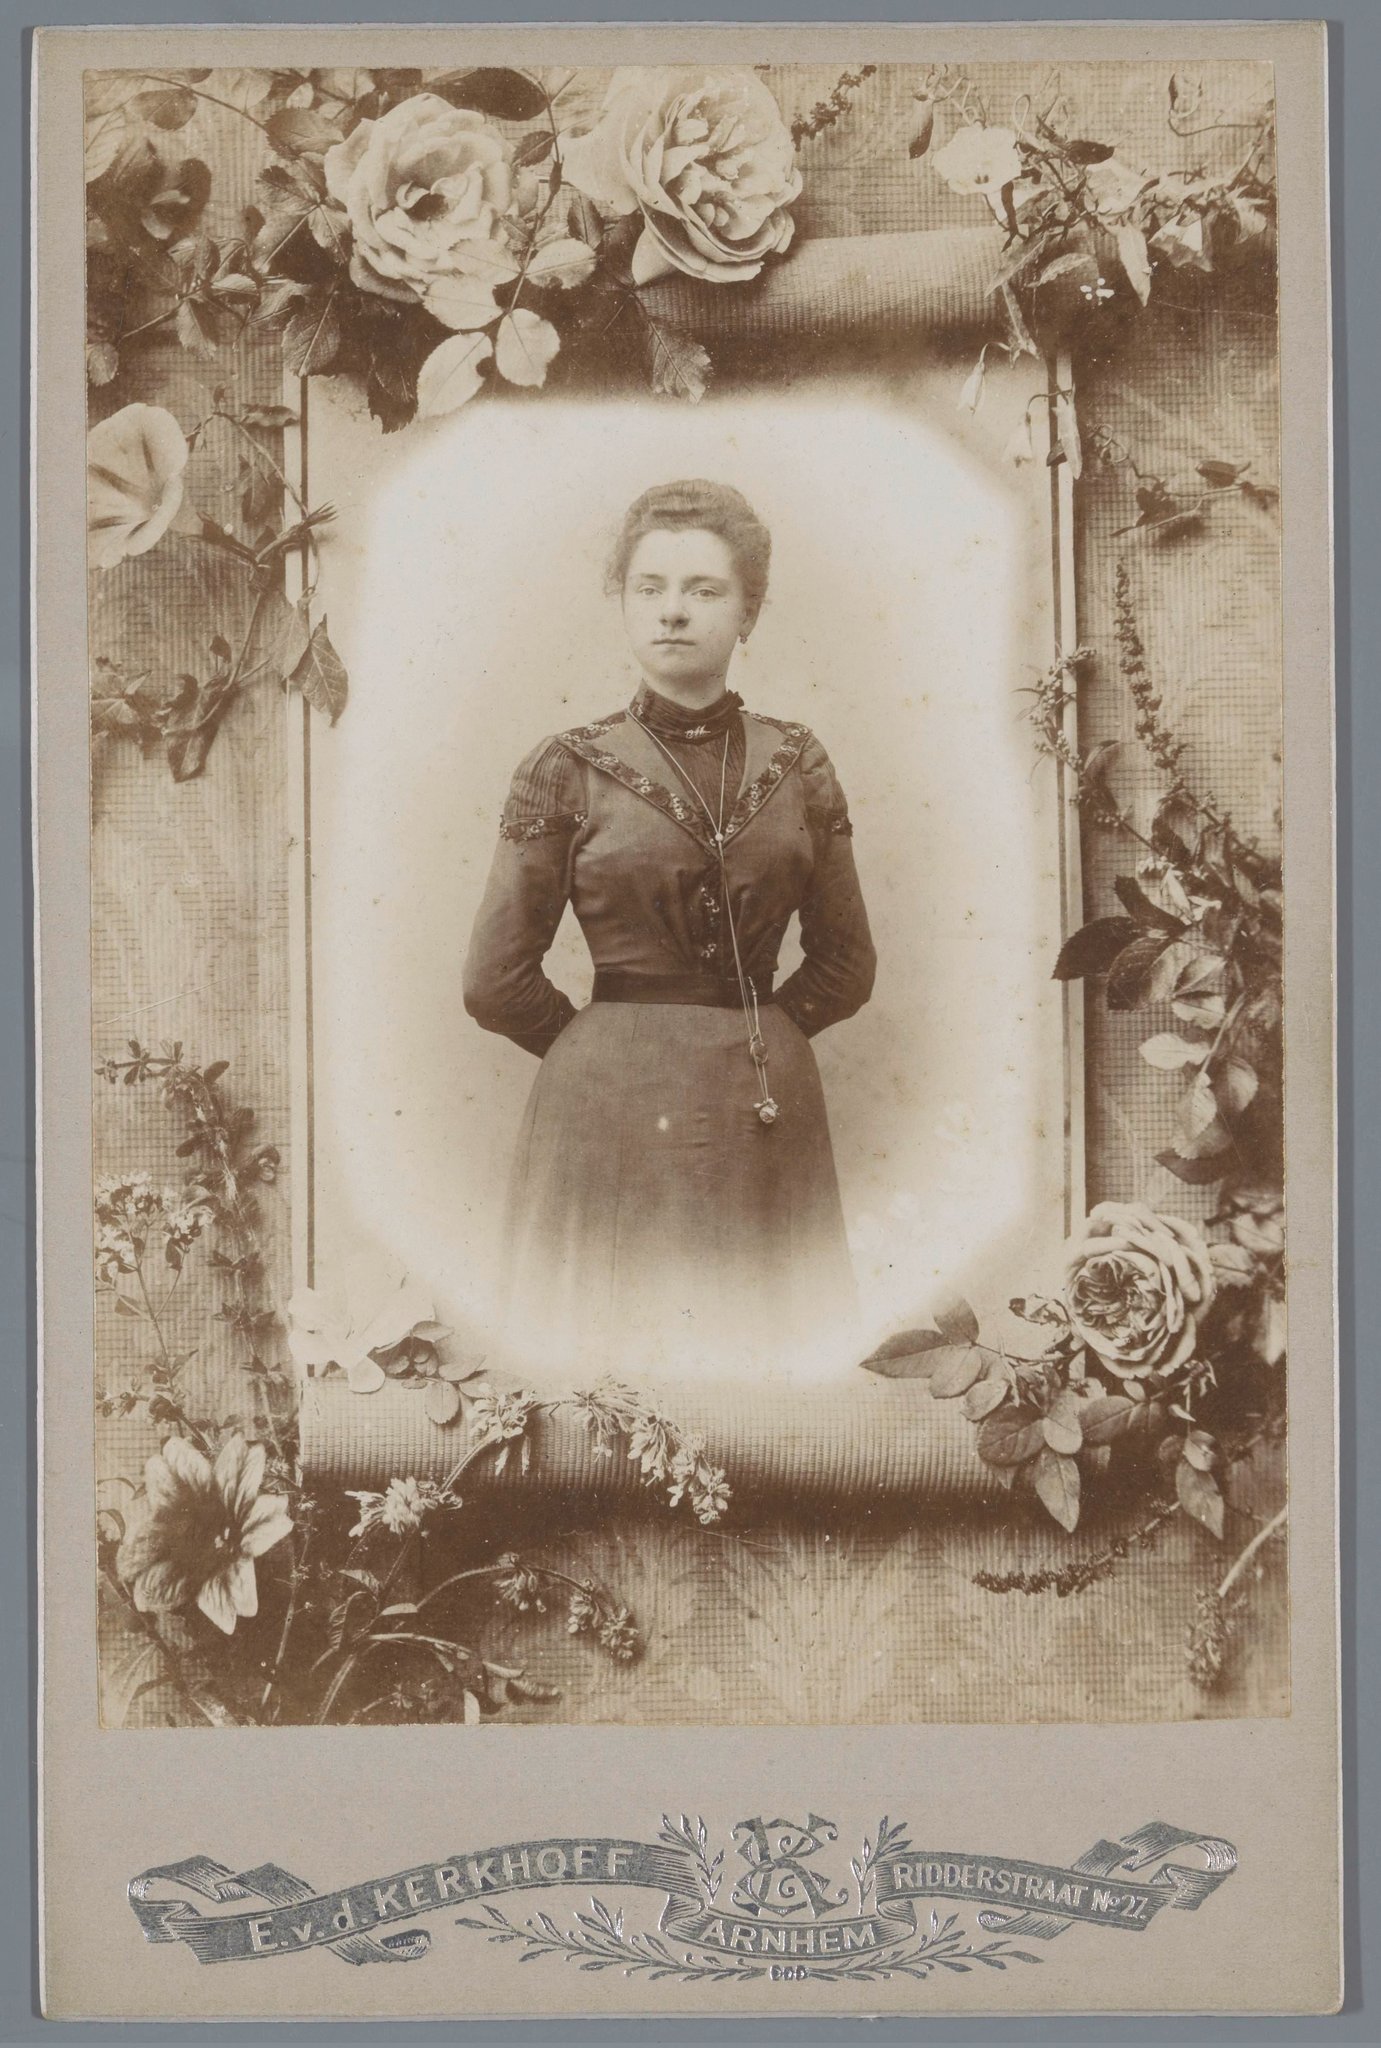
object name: cabinet photograph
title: Portret van een onbekende vrouw in een omlijsting met rozen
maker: e. v.d. kerkhoff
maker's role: fotograaf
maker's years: 1861-1943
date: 1895-1910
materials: cardboard, photographic support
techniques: gelatin silver print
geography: arnhem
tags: adult woman, flowers: rose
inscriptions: inscription: ‘E. v. d. Kerkhoff Ridderstraat No 27 Arnhem’